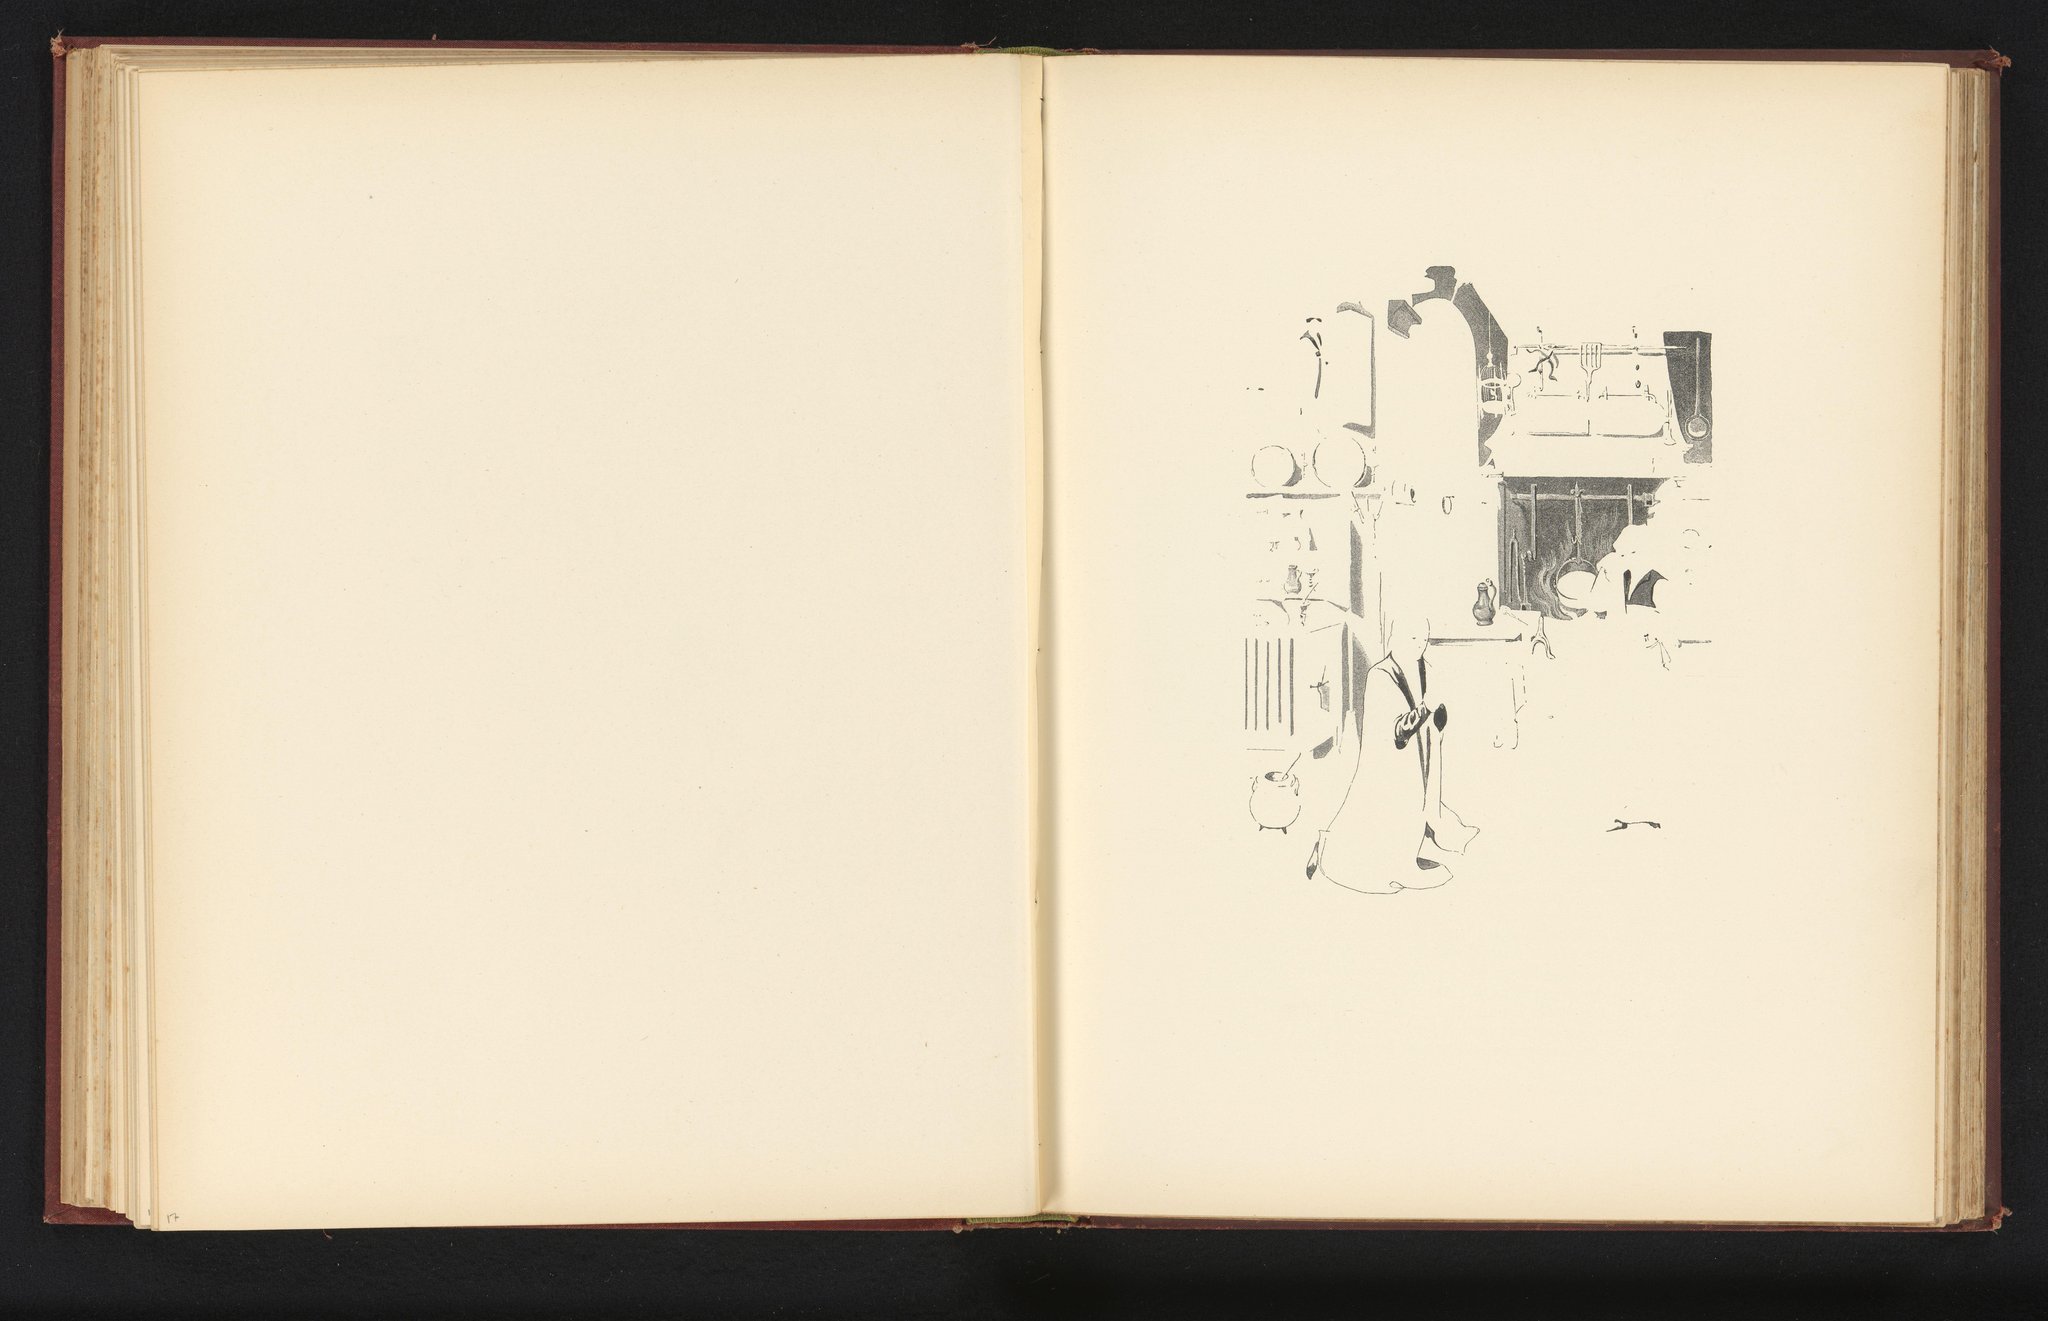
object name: print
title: Reproductie van het schilderij Het mirakel van de gebroken zeef, toonblok in zwart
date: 1889-1894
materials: paper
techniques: chromolithography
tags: kitchen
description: Prent op eenendertigste ongenummerde pagina na pagina 104.